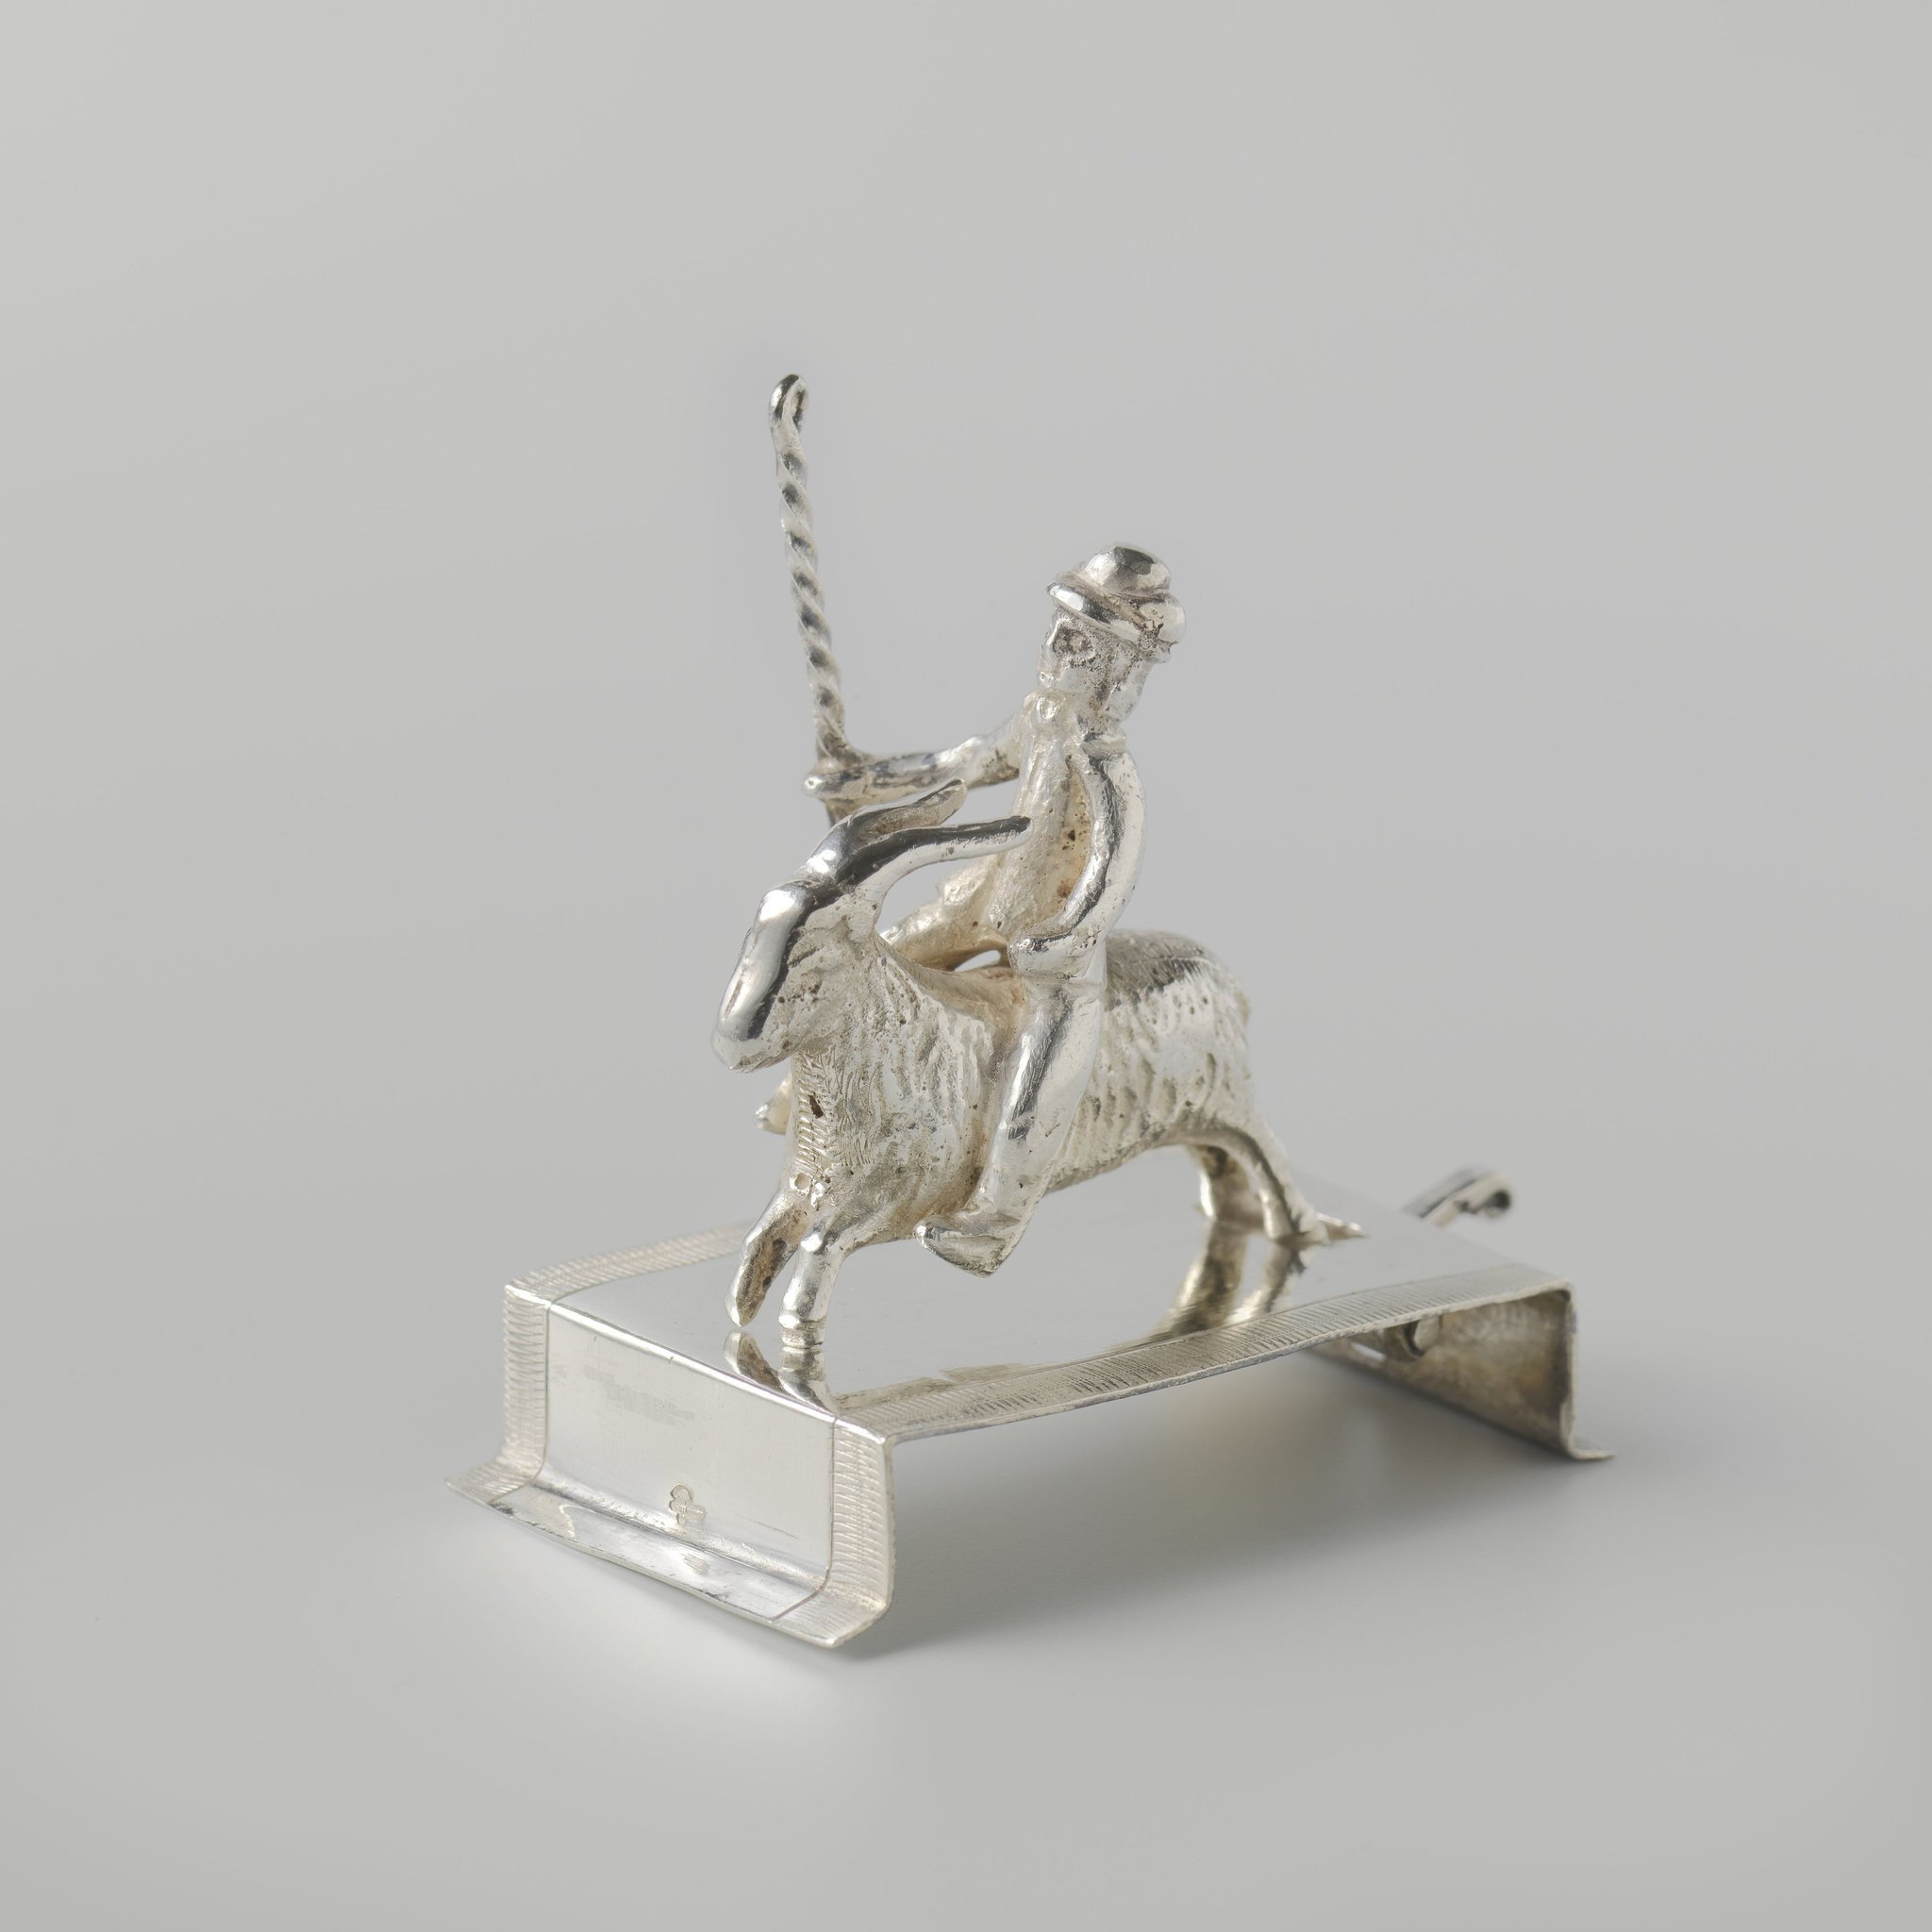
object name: miniature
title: Hobbelbok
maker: Anonymous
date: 1704-1734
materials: silver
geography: hoorn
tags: rocking-horse (+ variant)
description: Op een langwerpige plaat staat een bok met op zijn rug een man. De man heeft een gedraaide zweep in zijn rechterhand. De uiteinden van de plaat zijn naar beneden en naar buiten gebogen en dienen nu als steunen voor de plaat. In de plaat en in een van de steunen zit een gat waardoor een hendel steekt die aan de achterpoten van de bok is bevestigd. Door de hendel te bewegen, gaat de bok op en neer. Het beeld is gemerkt: stk.= Hoorn, een bijltje en een onbekend meesterteken.